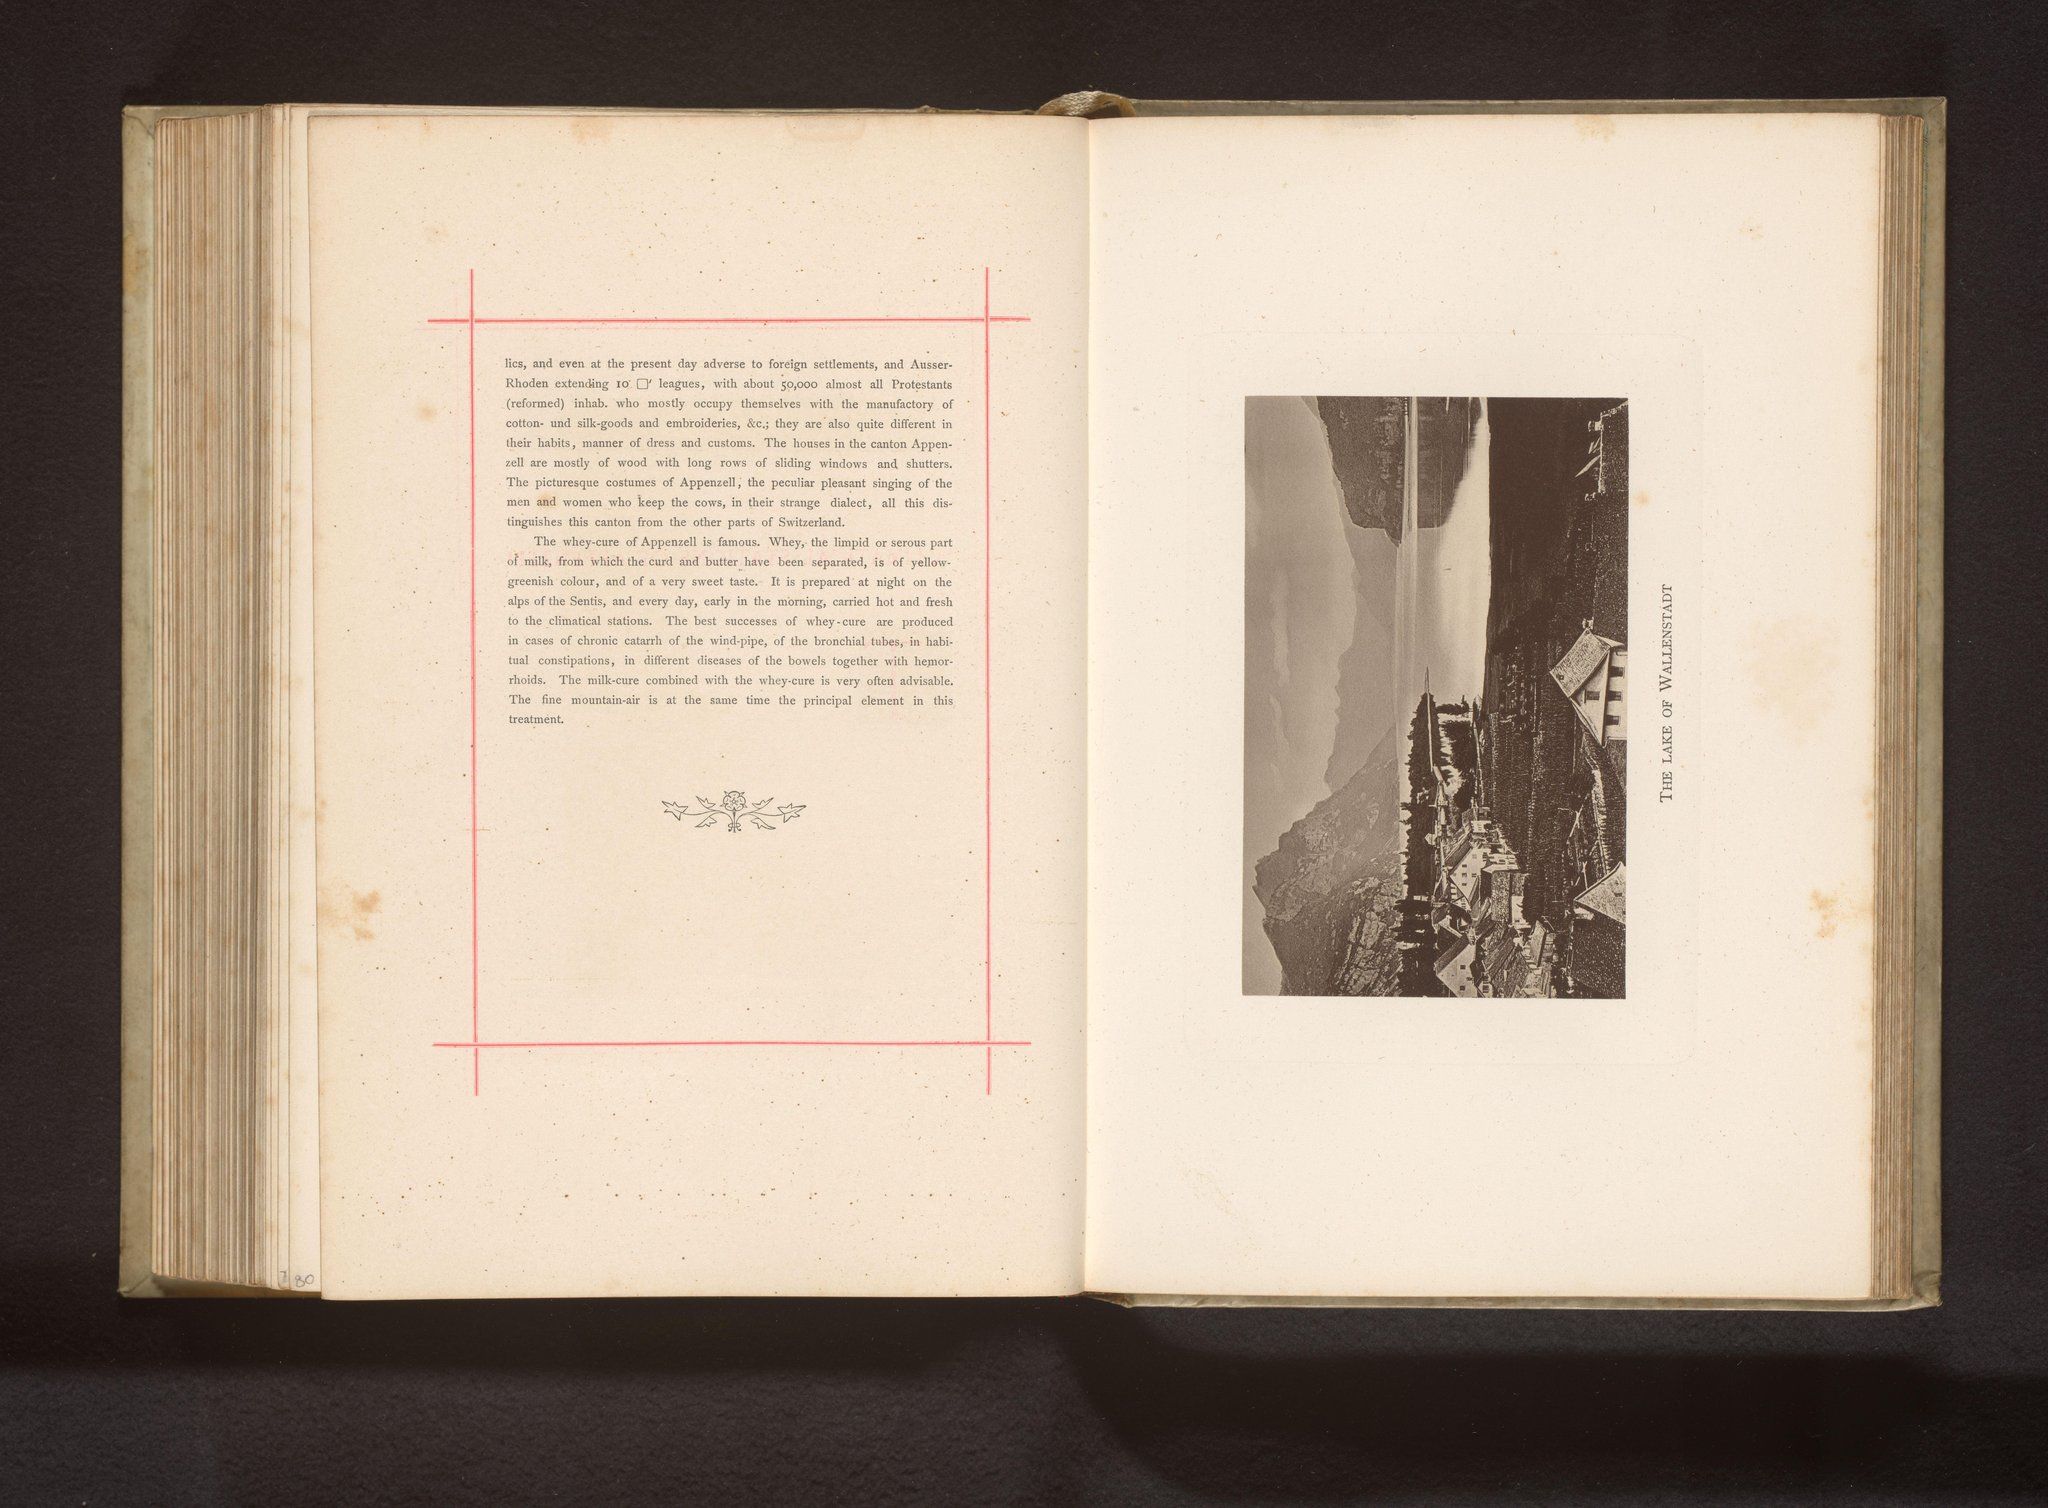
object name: page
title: The lake of Wallenstadt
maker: Anonymous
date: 1874-1884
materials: paper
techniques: photograph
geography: switzerland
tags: lake, mountains